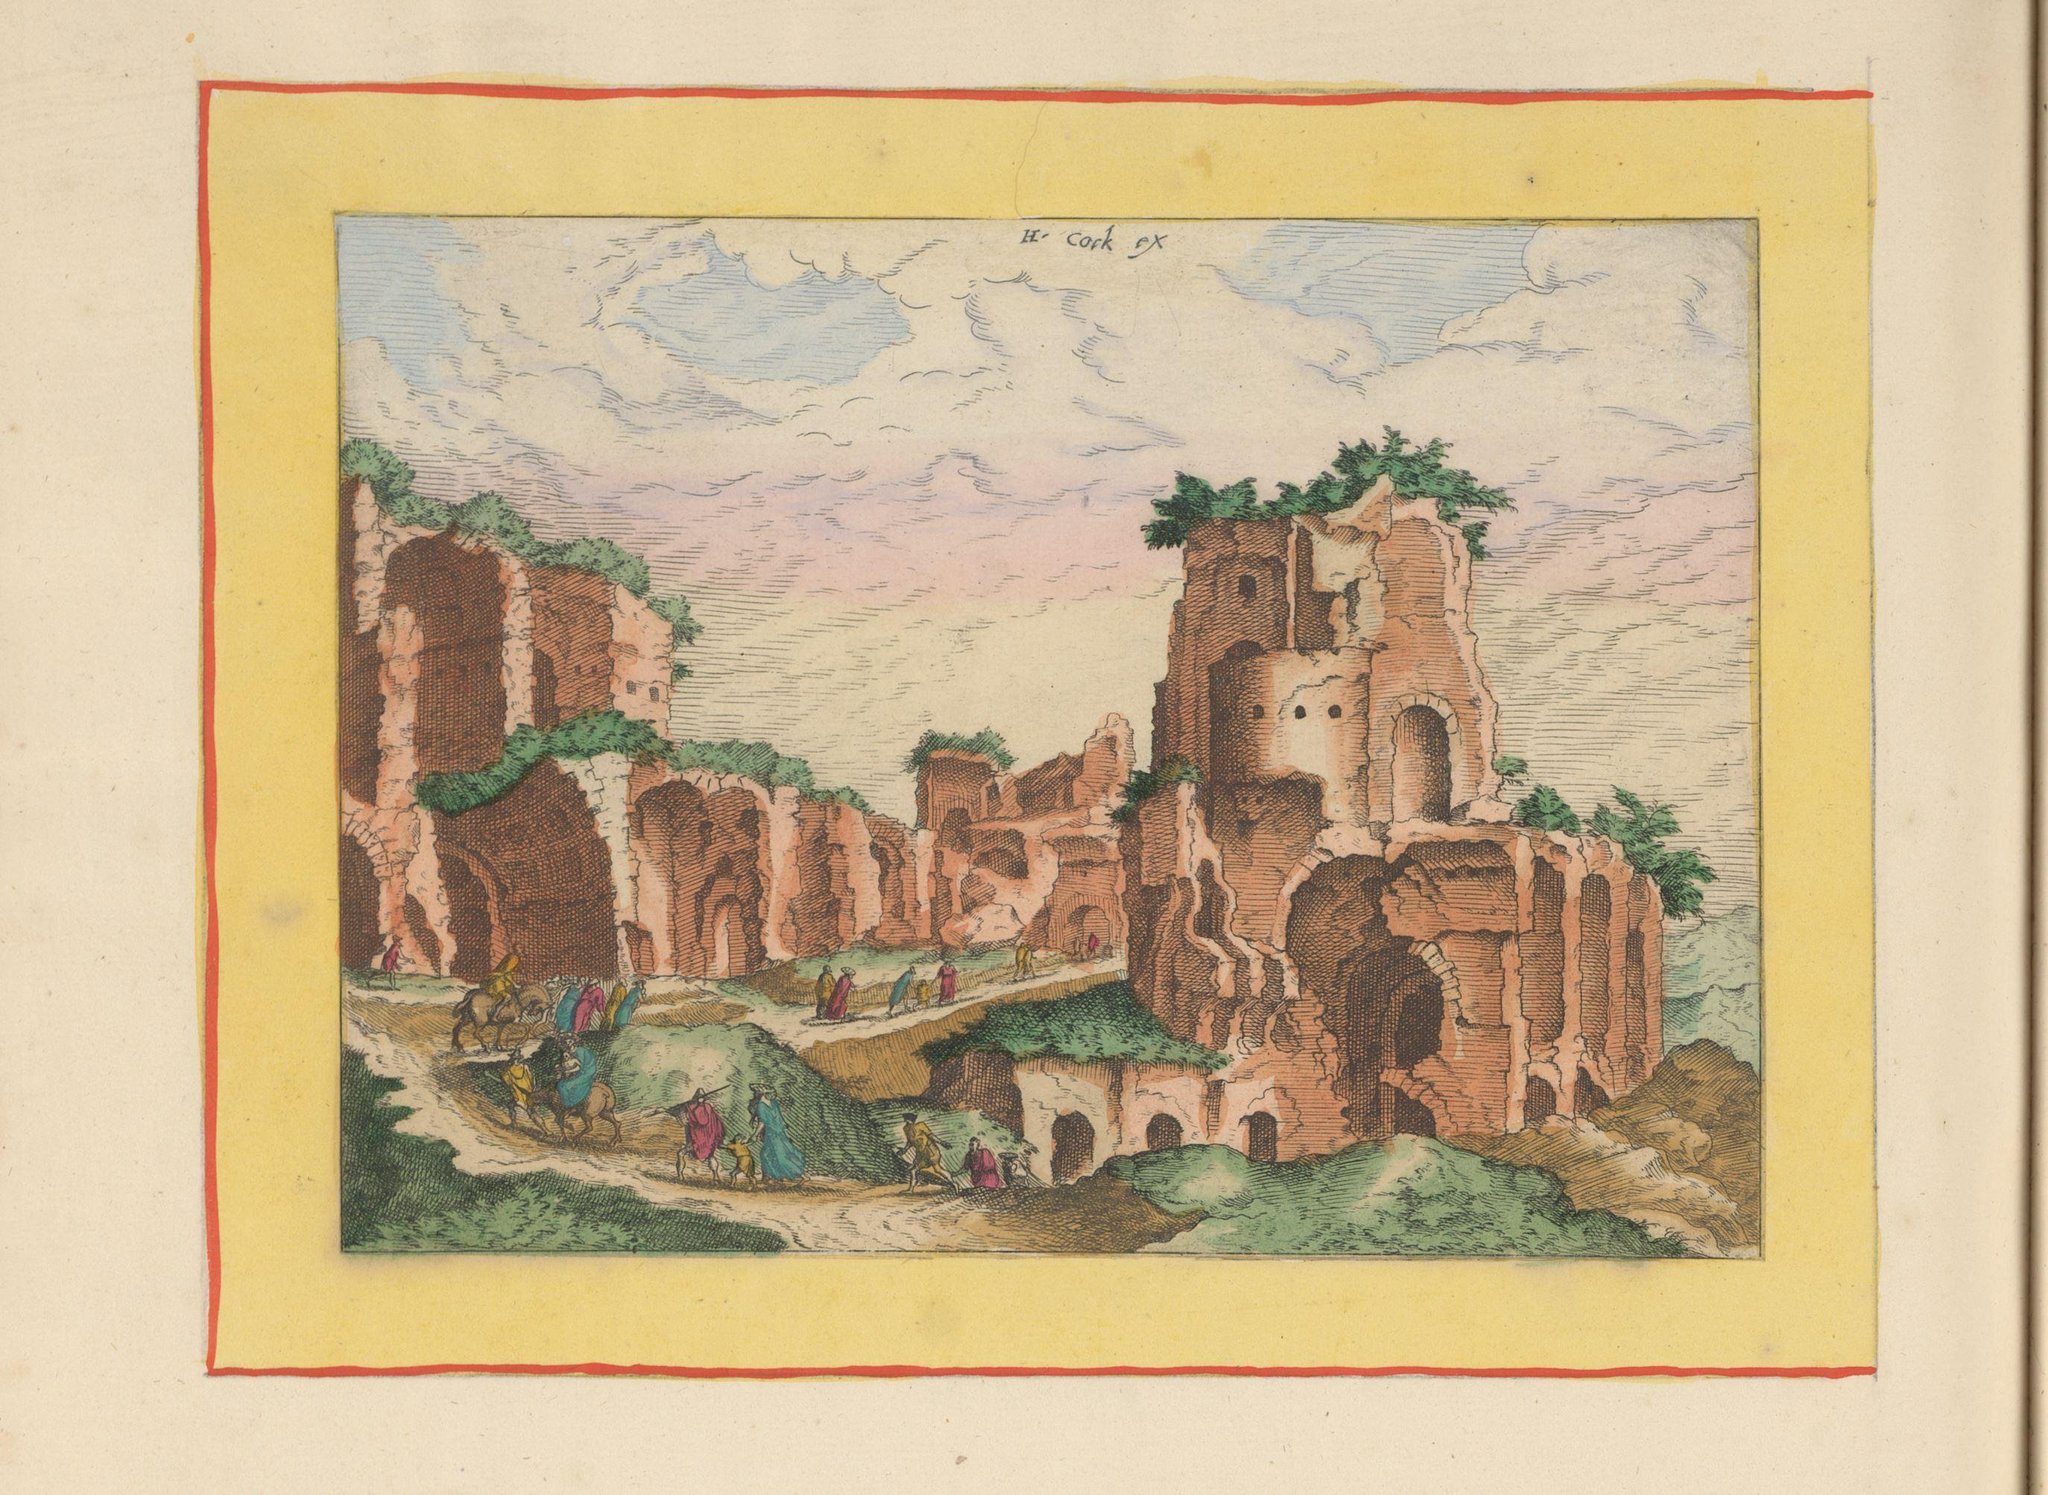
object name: print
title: Romeinse ruïnes en gebouwen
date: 1562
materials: paper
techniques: colour, etching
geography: antwerp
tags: ruin of a building ~ architecture, landscape with ruins, rome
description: Gezicht op de ruïnes op de Palatijn te Rome. Op de voorgrond lopen verschillende figuren over een pad richting de ruïnes. Prent maakt deel uit van een album.